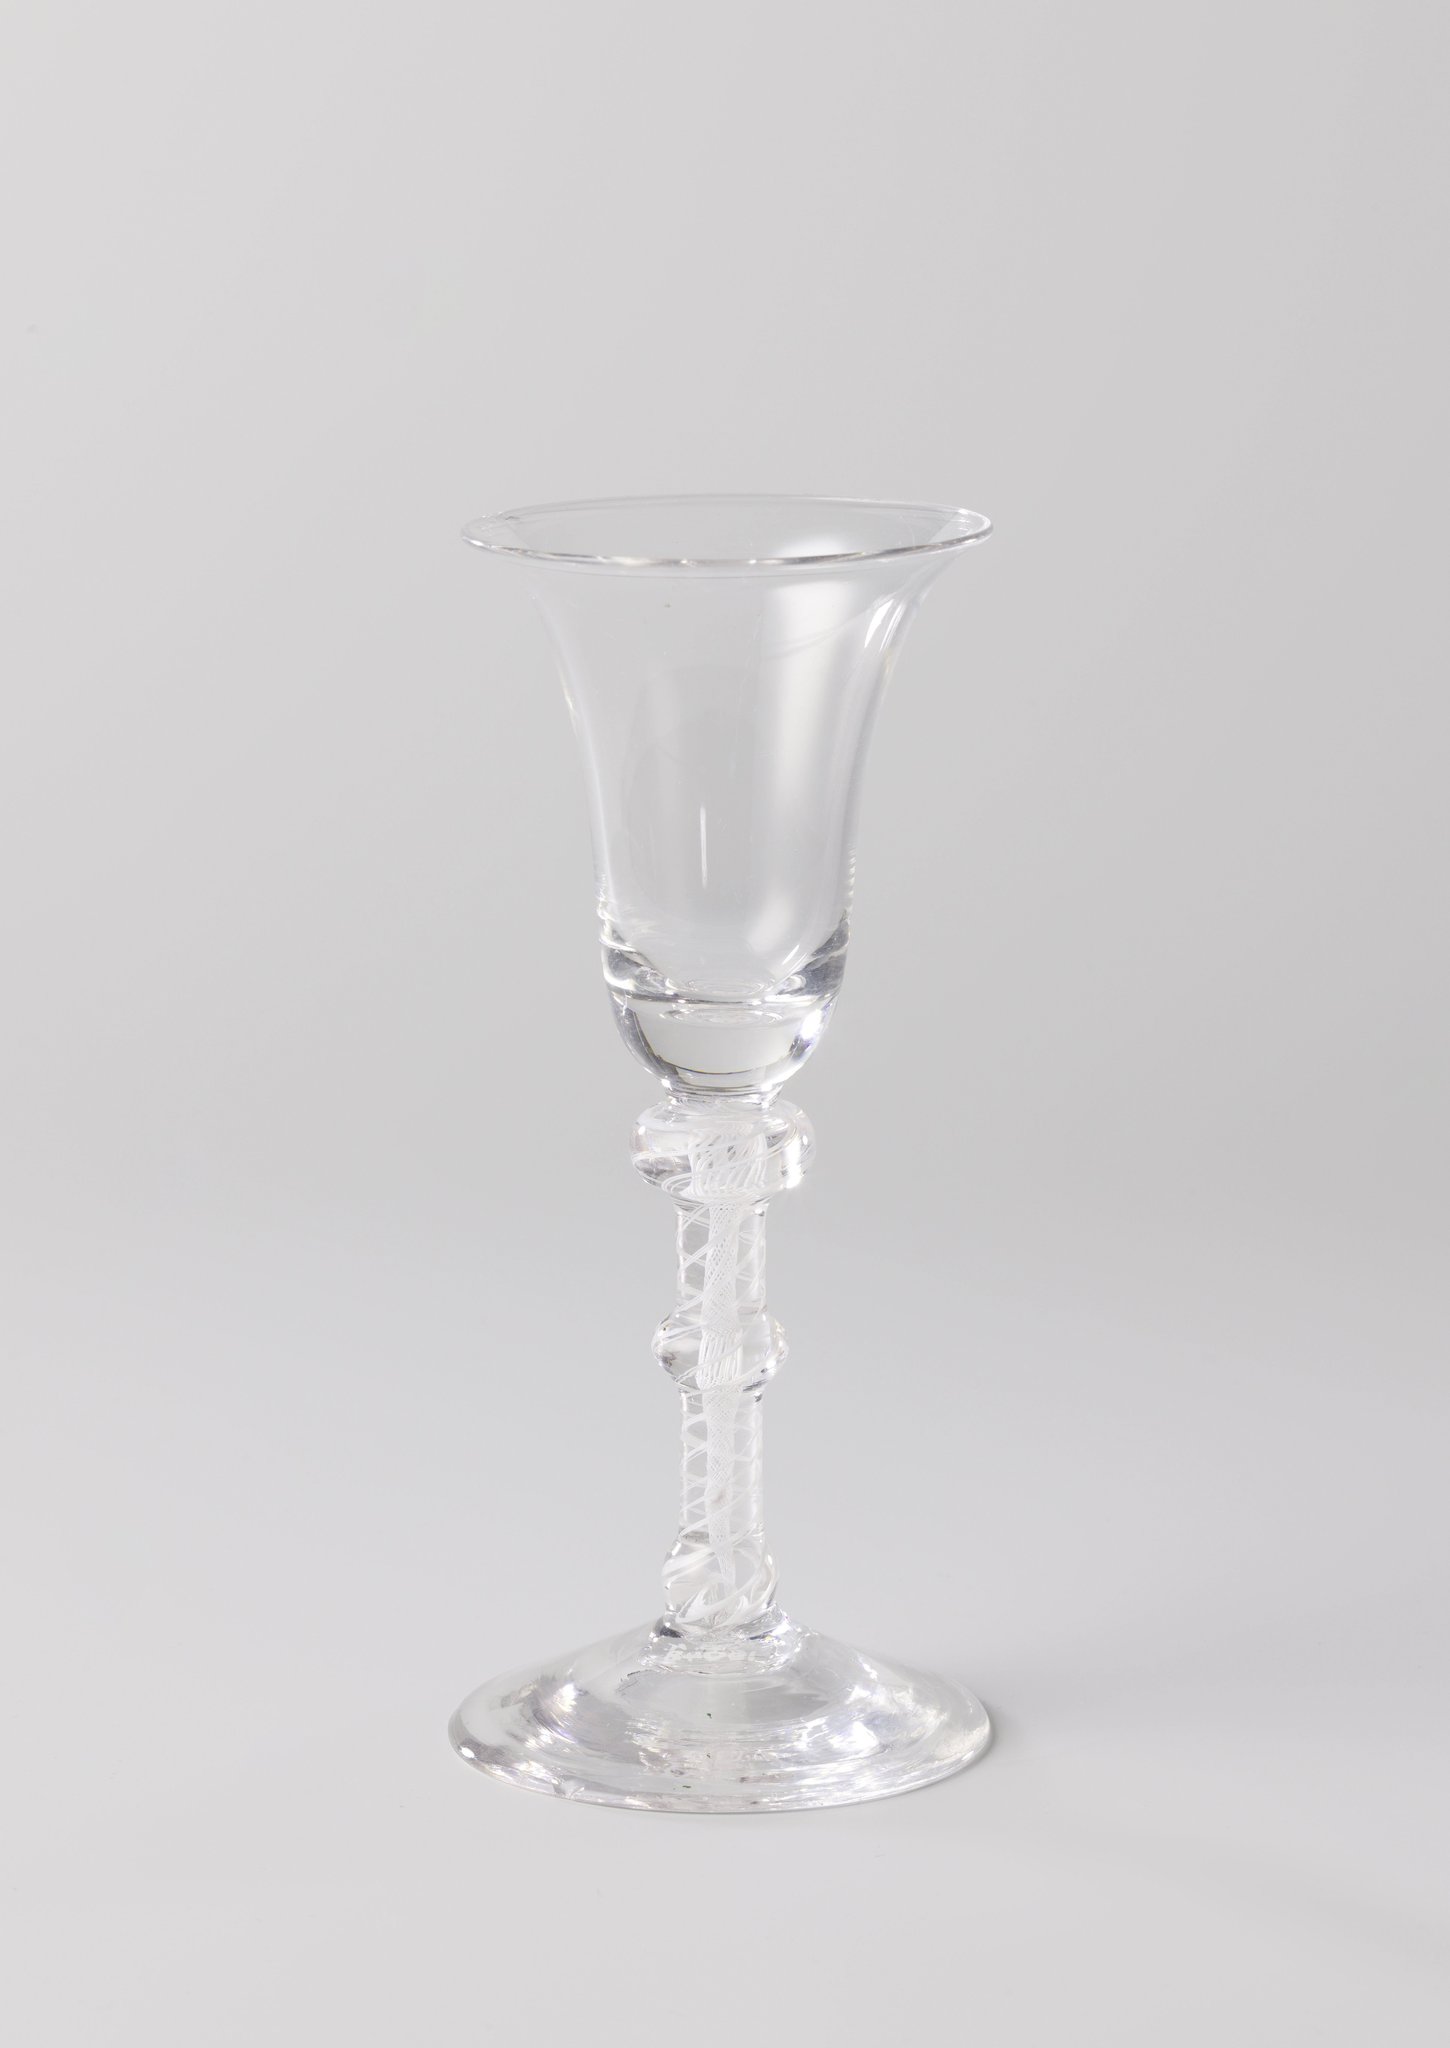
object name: slingerglas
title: Slingerglas met klokvormige kelk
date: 1750-1775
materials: glass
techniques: glassblowing, vetro a retorti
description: Slingerglas met conische voet en balustroïde stam. In de stam opaak witte slingers rond witte netwerkspiraal. Klokvormige kelk.